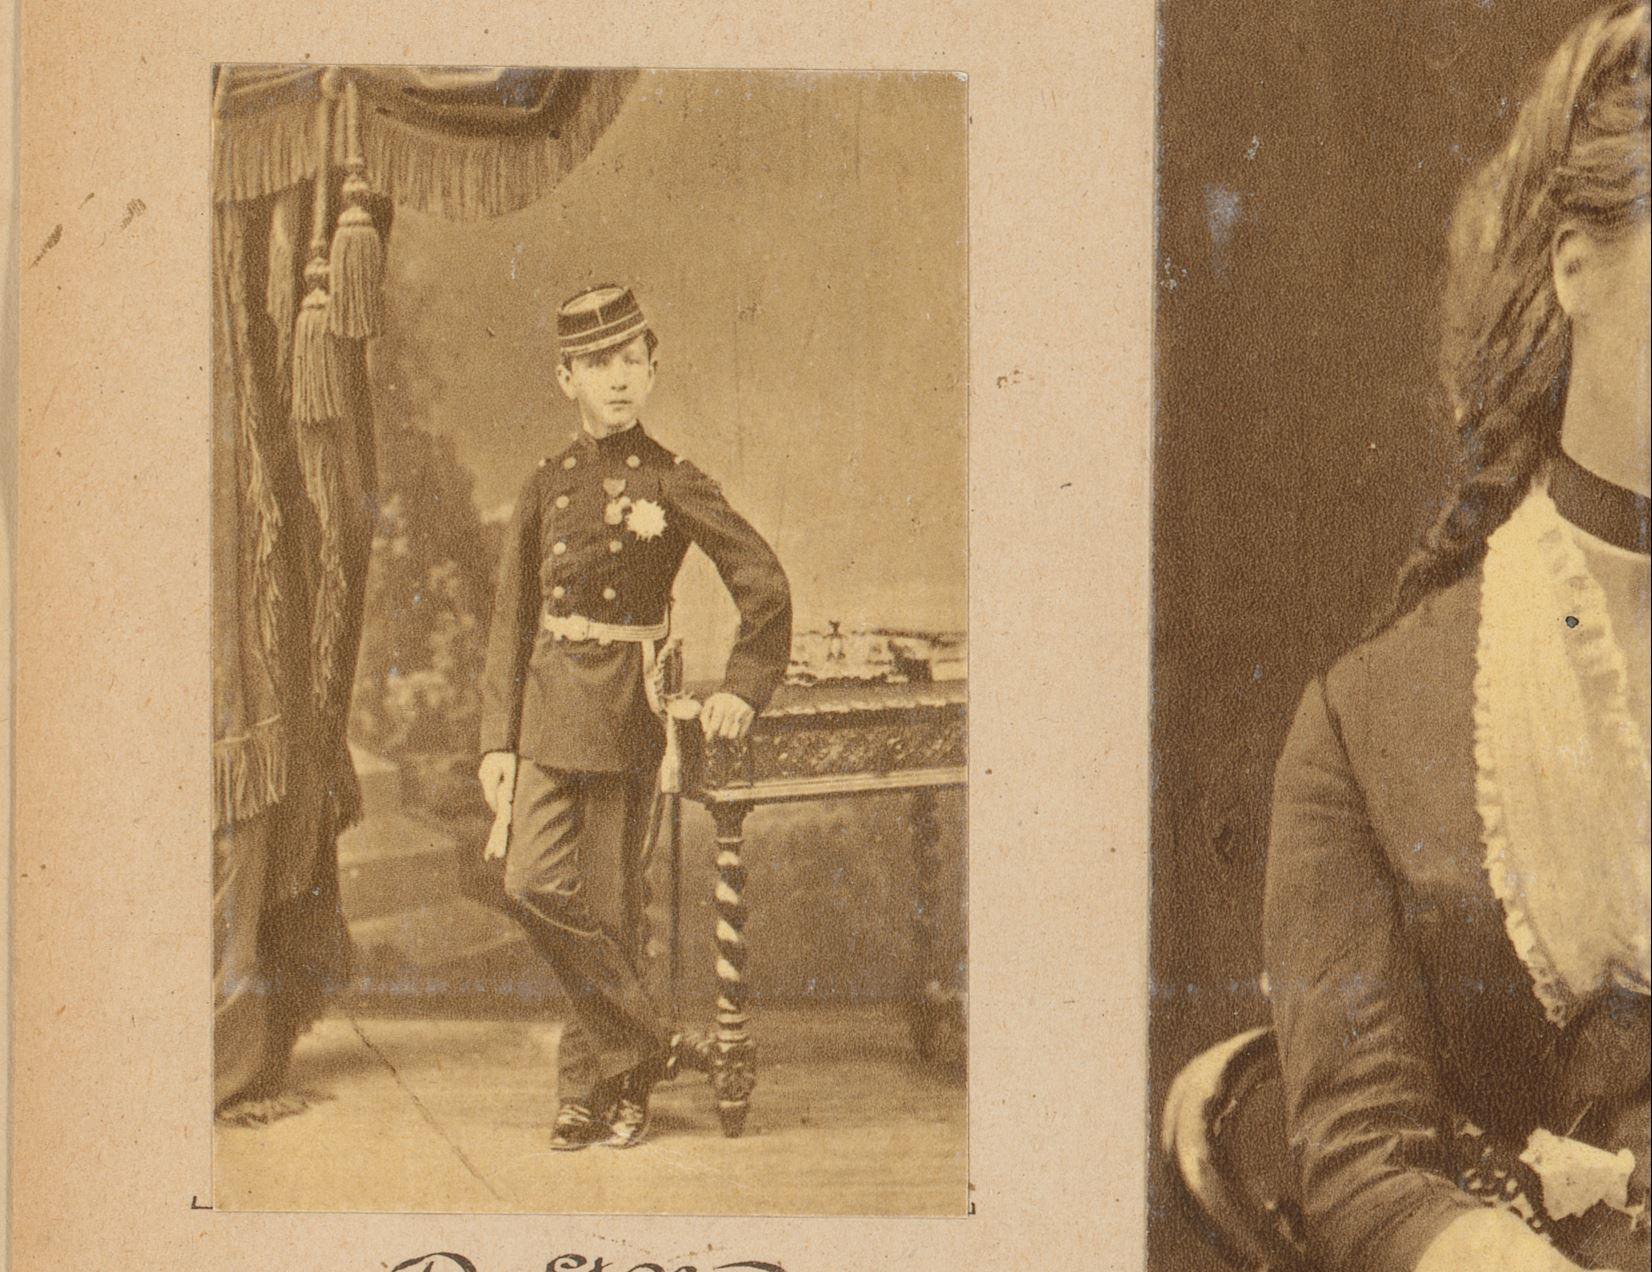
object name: photograph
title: La fin douloureuse d'une dynastie impériale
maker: Anonymous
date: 1870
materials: paper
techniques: rotogravure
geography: saint-cloud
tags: paris, historical persons, emperor